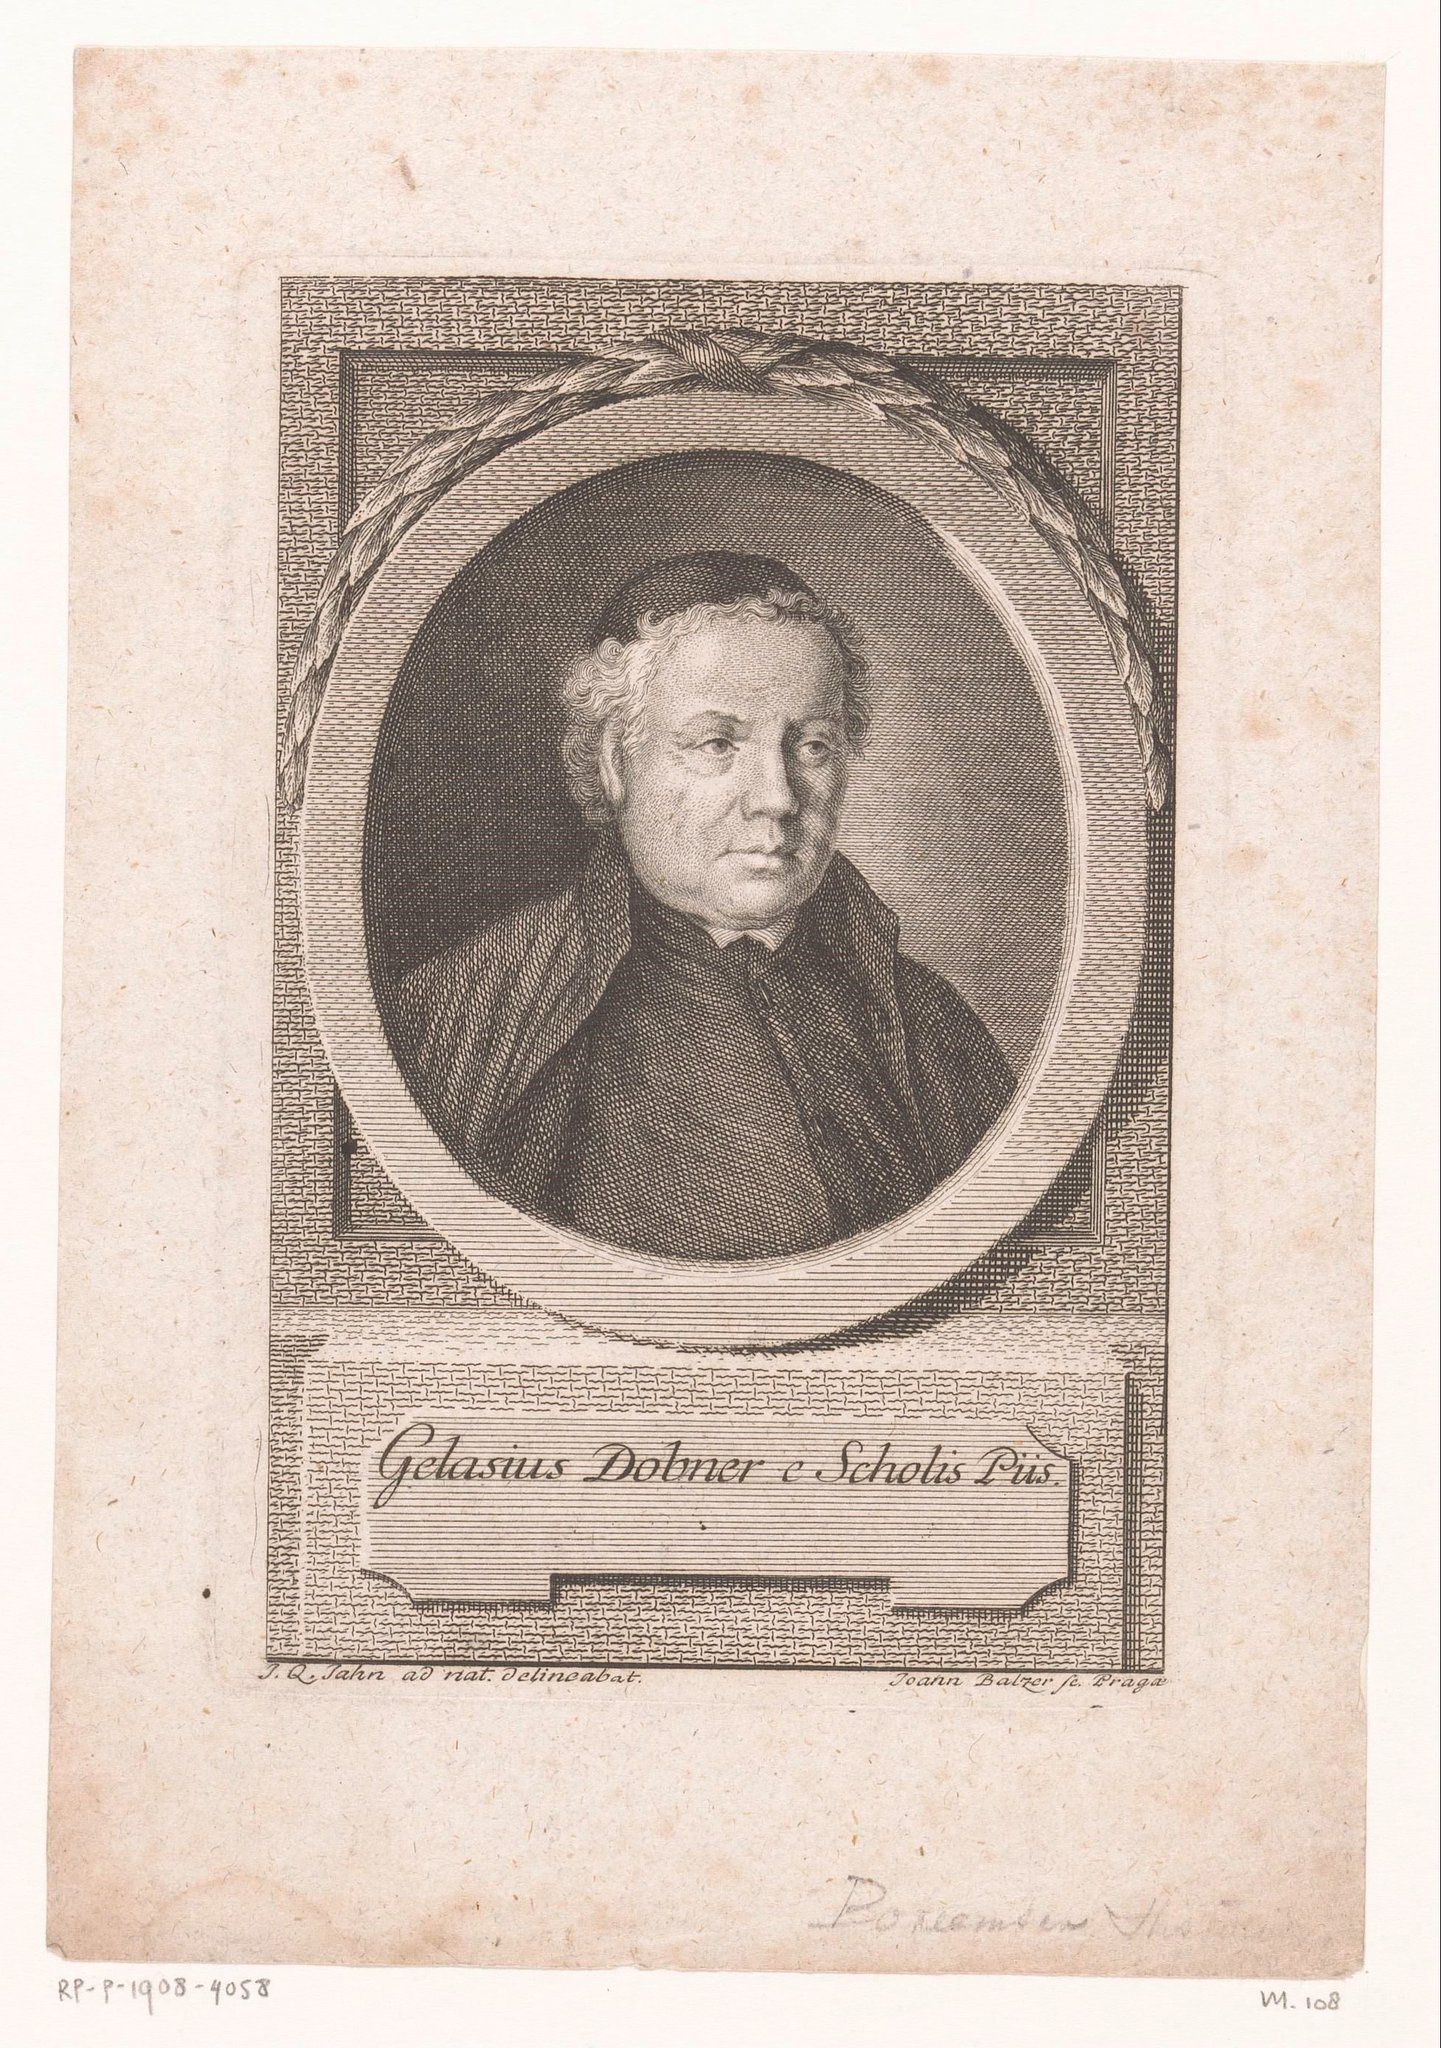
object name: print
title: Gelasius Dobner e Scholis Piis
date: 1749-1799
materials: paper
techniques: engraving, etching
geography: prague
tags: prague, priest, historical persons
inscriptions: collector's mark: Lugt 2228